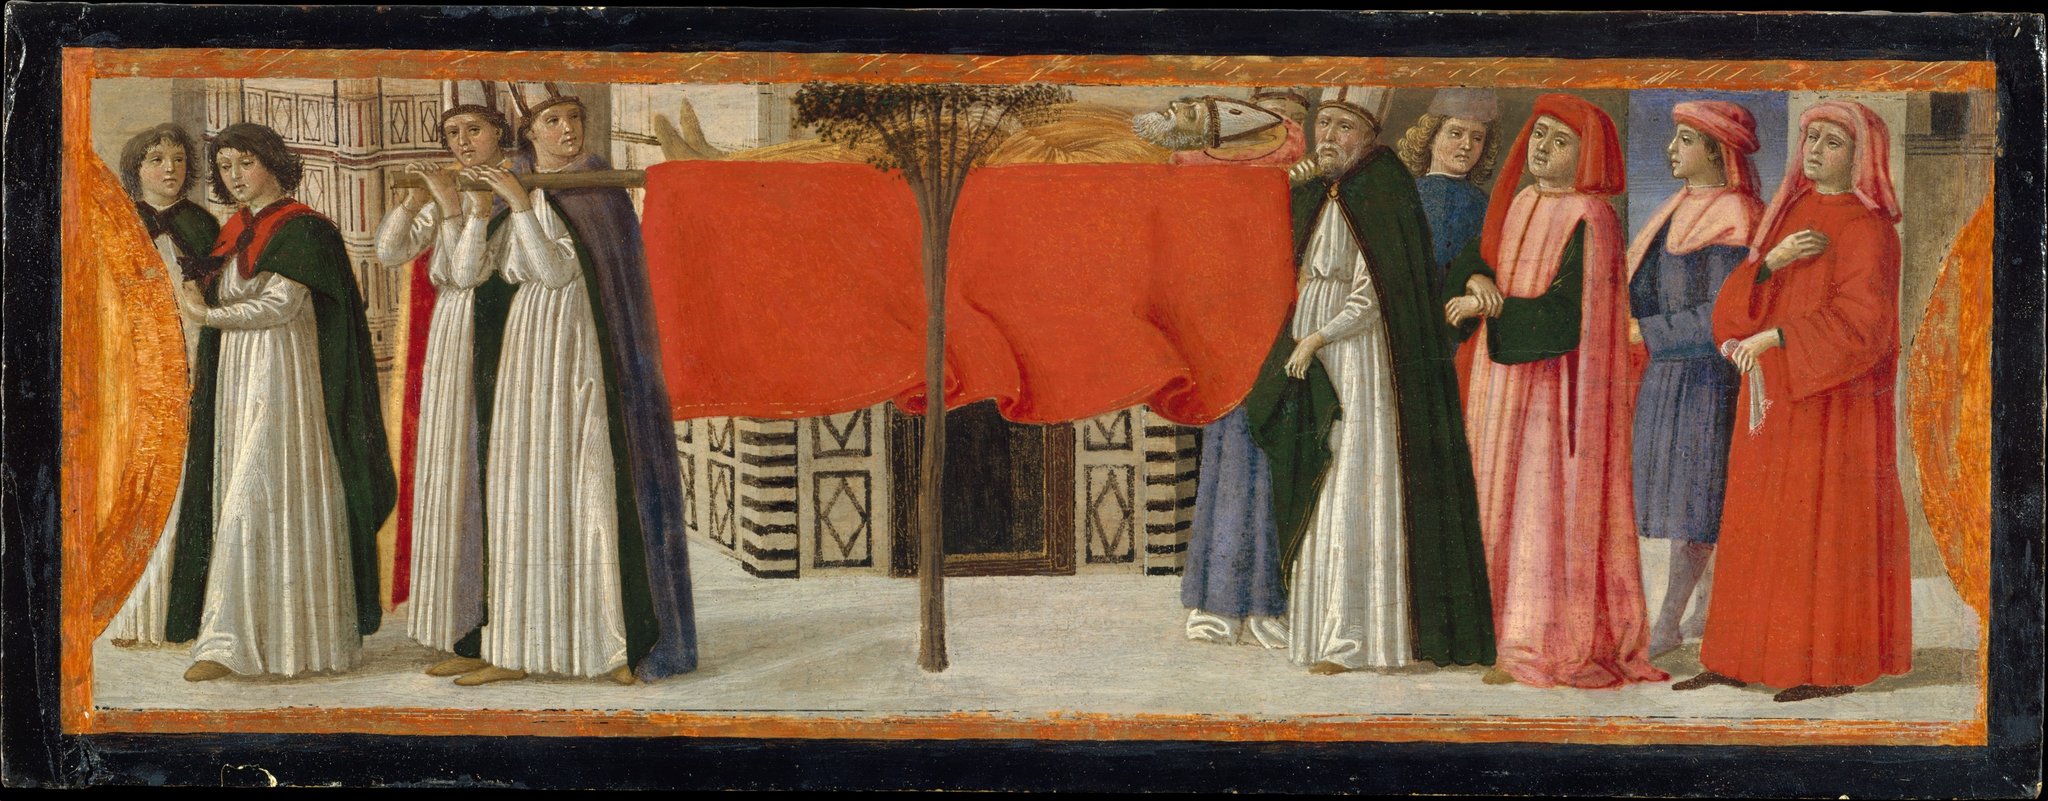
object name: painting, predella panel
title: The Burial of Saint Zenobius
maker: davide ghirlandaio (david bigordi)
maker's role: artist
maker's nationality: italian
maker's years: 1452-1525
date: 1479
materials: gold, paint, wood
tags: men,women,saints,funerals